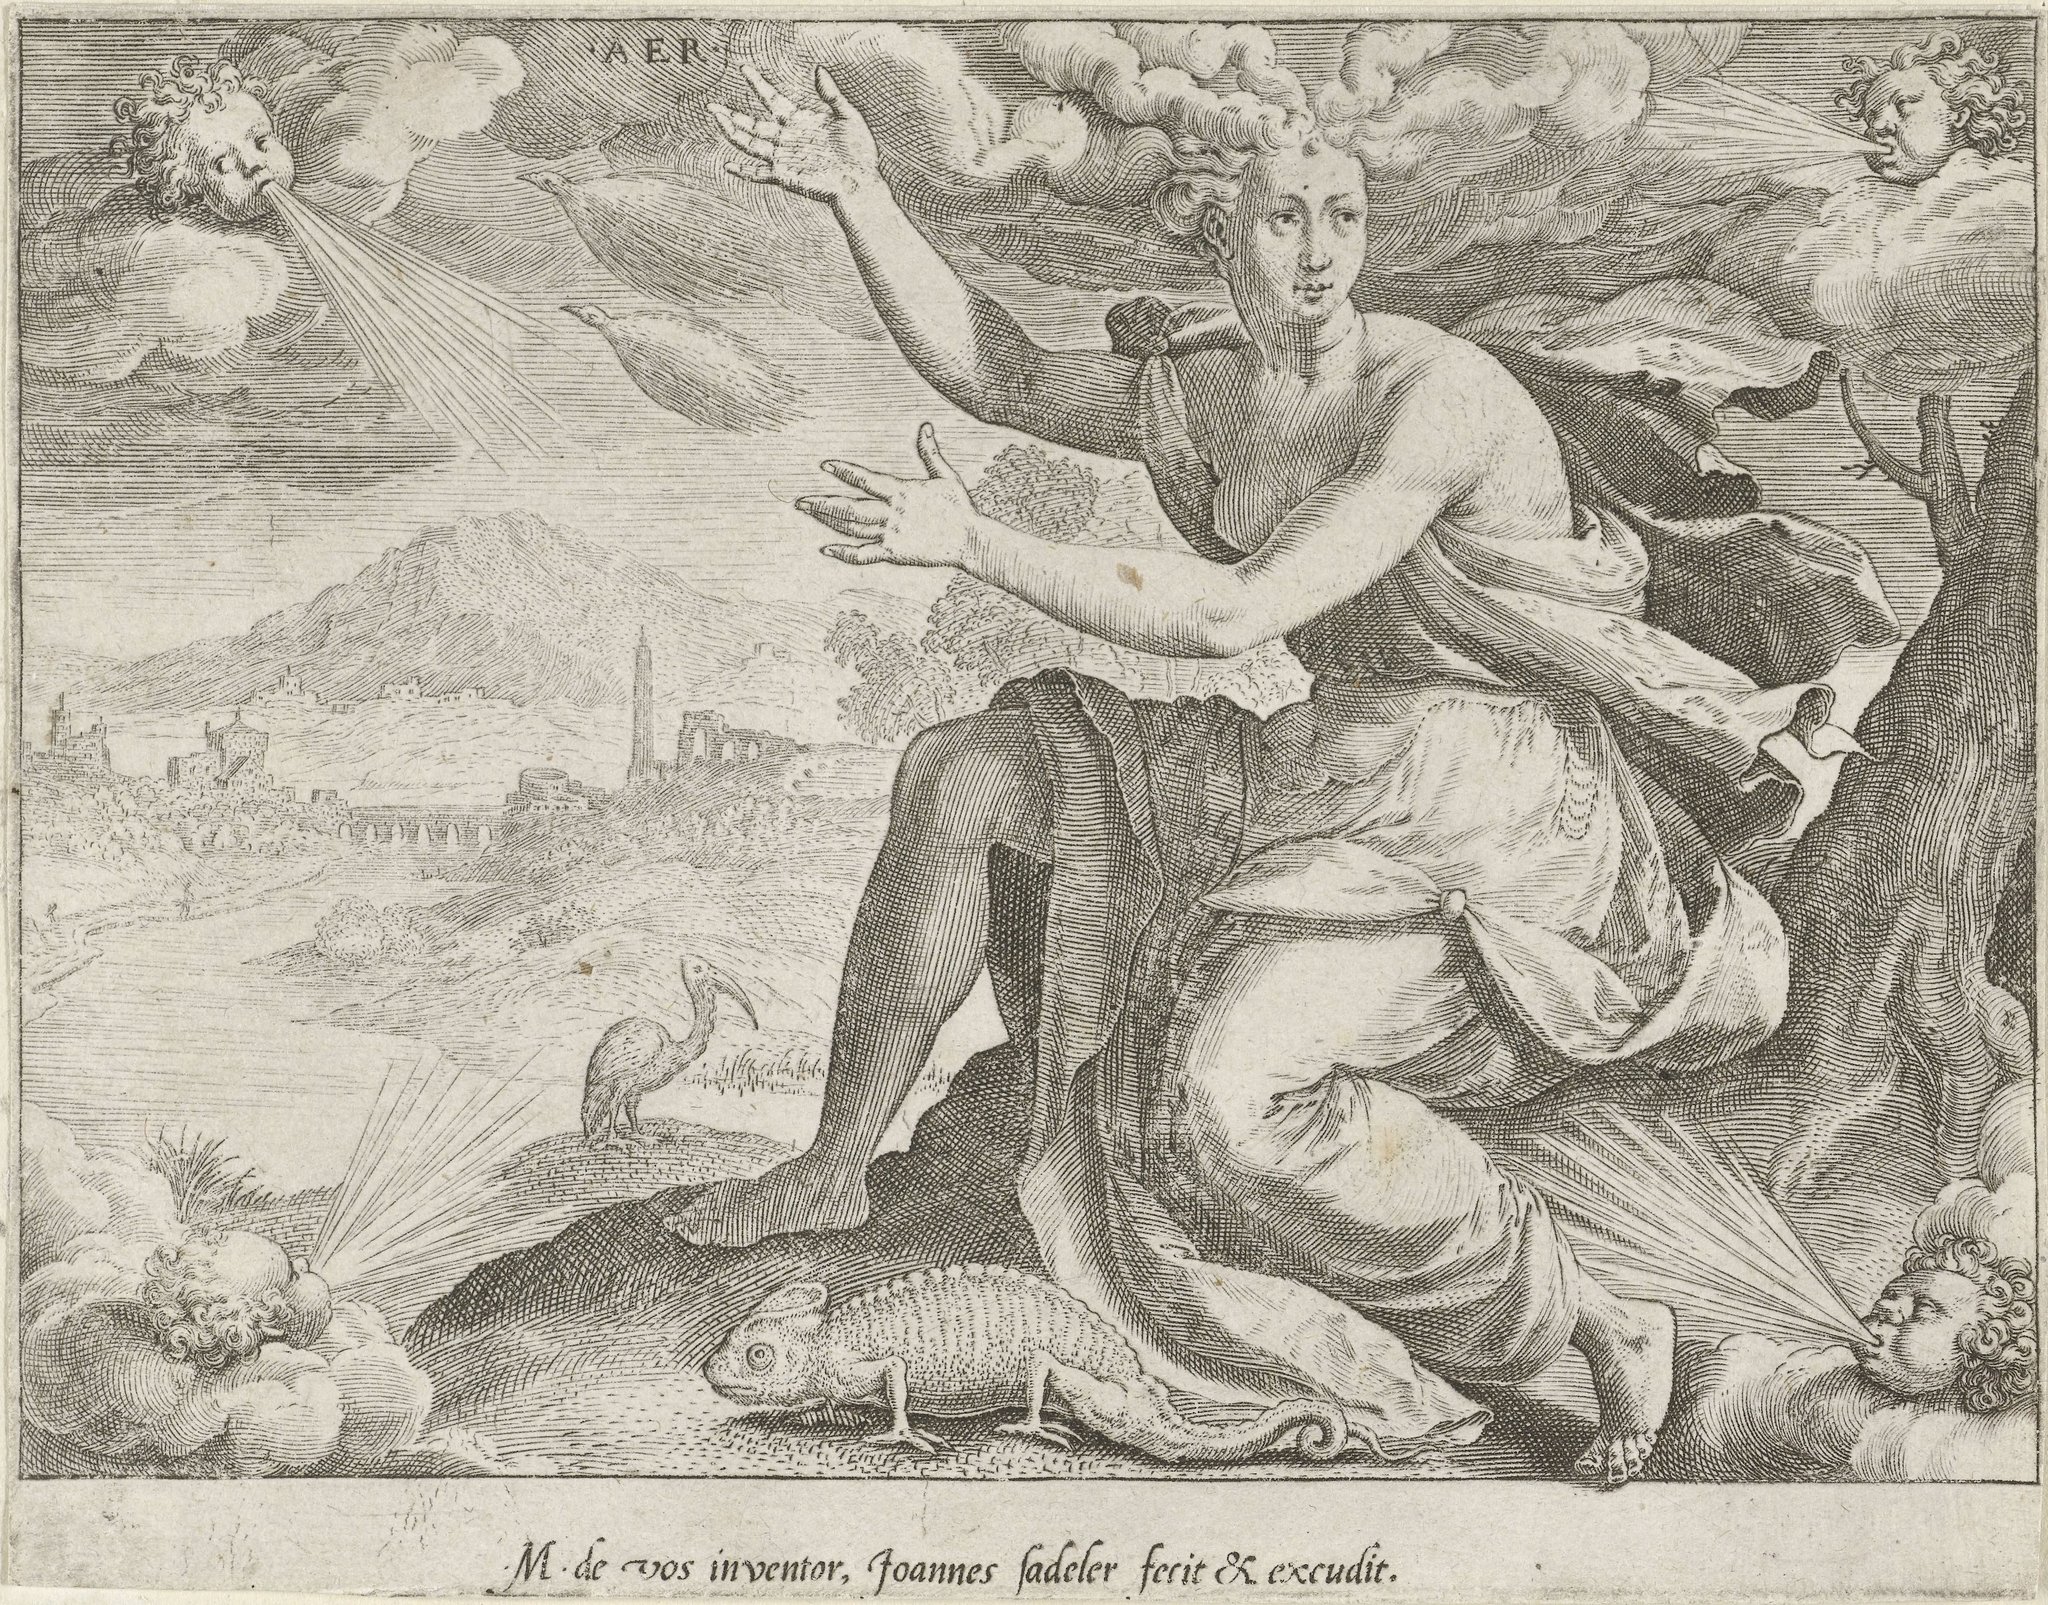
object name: print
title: Lucht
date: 1560-1600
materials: paper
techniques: engraving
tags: air (one of the four elements), winds, lizards: chameleon, mountains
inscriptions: collector's mark: Lugt 240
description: De vrouwelijke personificatie van het element lucht. Rondom haar hoofd wolken. Aan haar voeten een kameleon. In de vier hoeken een blazende wind. De prent maakt deel uit van een serie met als onderwerp de vier elementen.